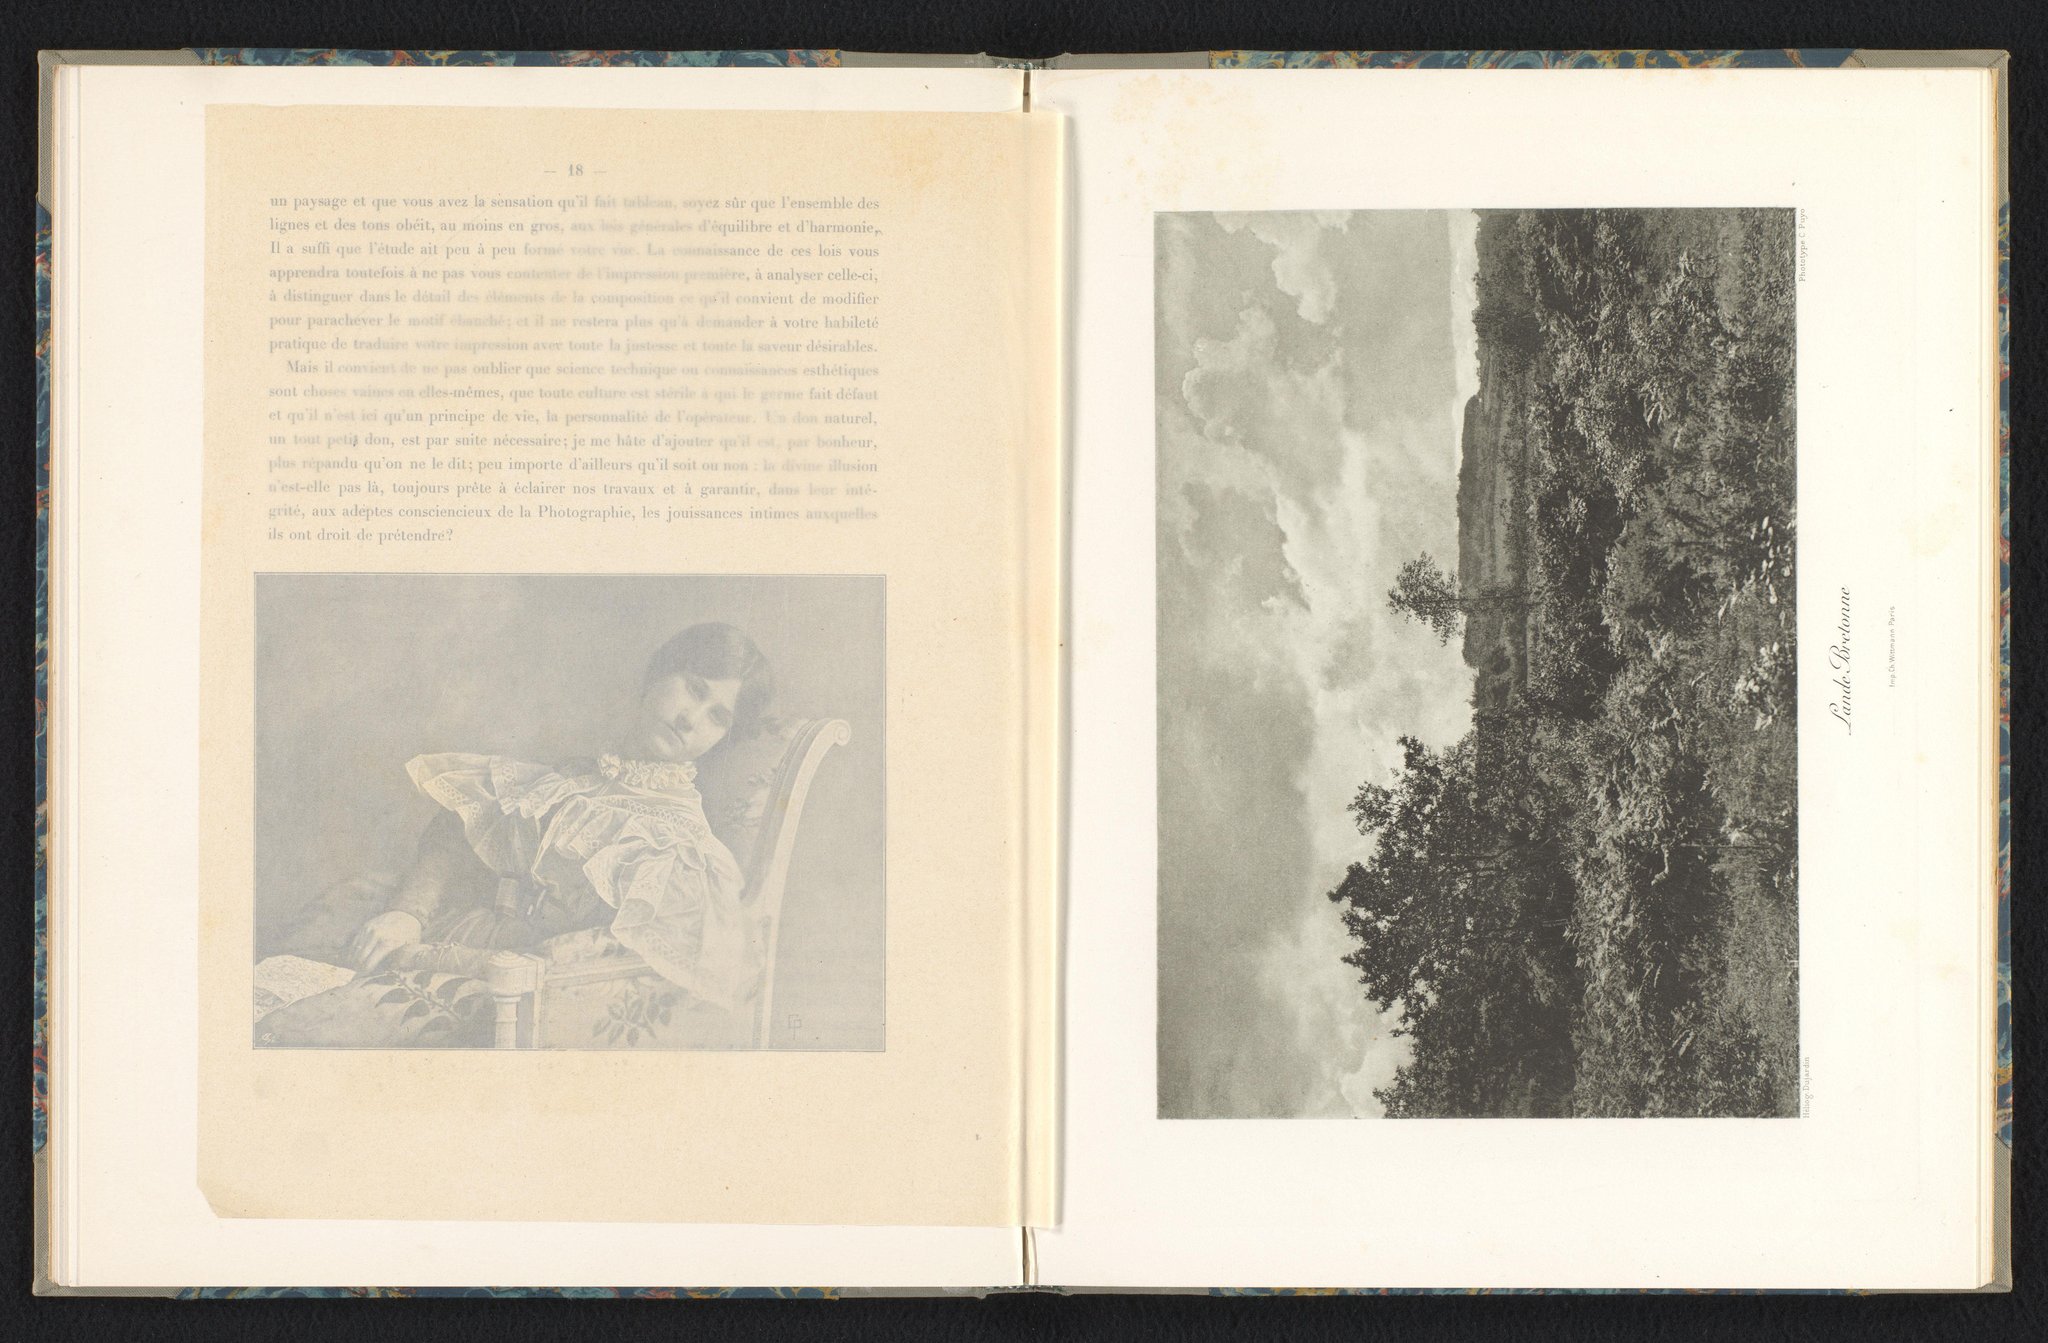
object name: page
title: Landschap in Bretagne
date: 1891-1896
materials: paper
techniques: photoaquatint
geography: paris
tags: forest, wood